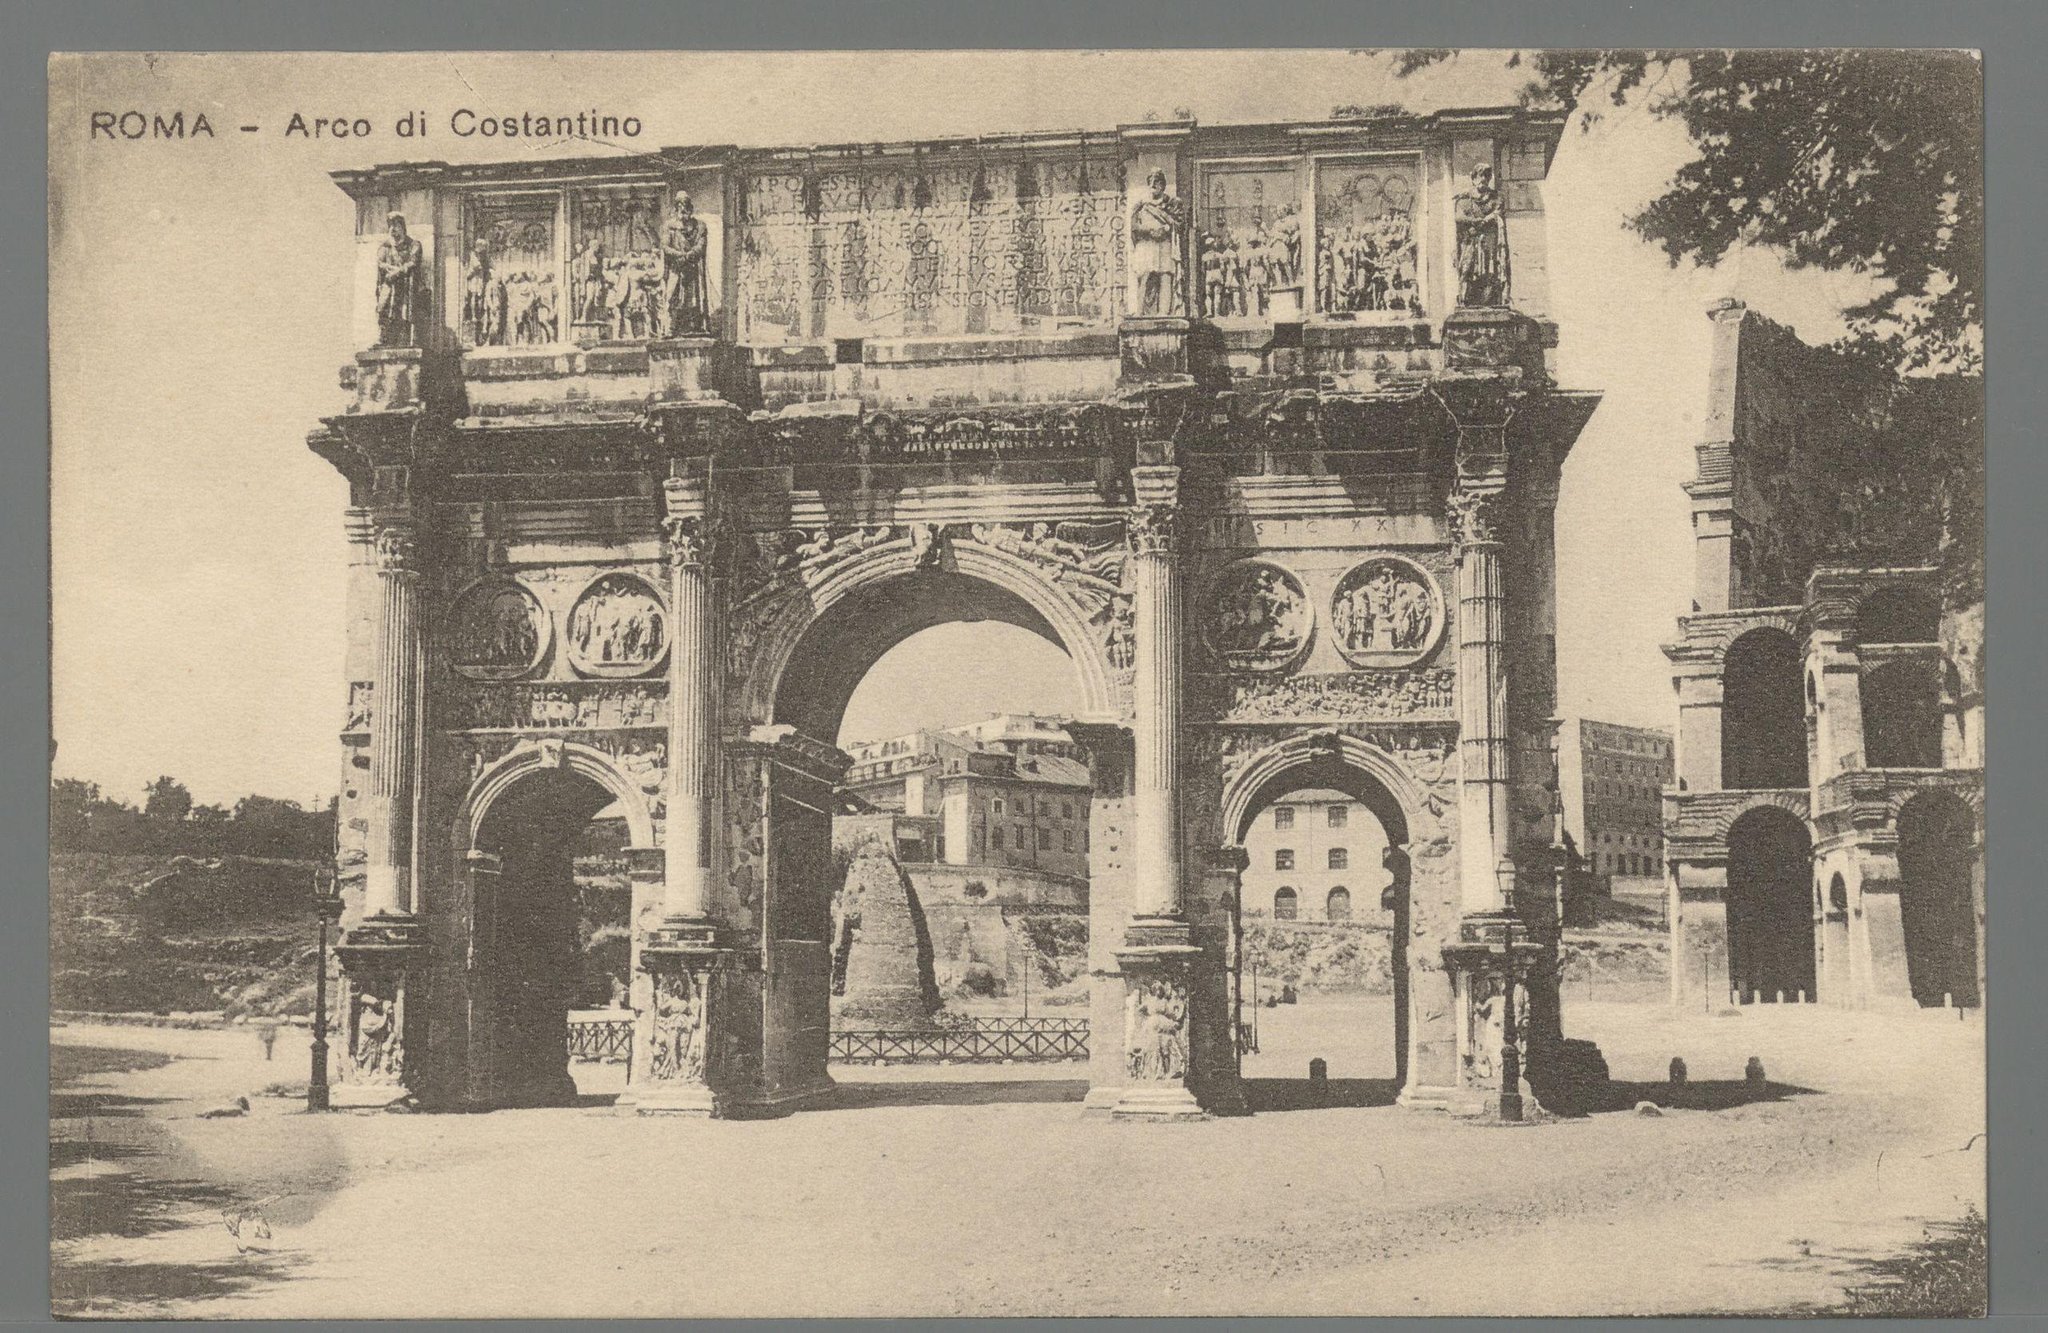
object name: photomechanical print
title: Roma. Arco di Costantino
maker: Anonymous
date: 1906-1920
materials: cardboard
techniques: photograph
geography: rome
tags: city-view, and landscape with man-made constructions, triumphal arch, arch of constantine